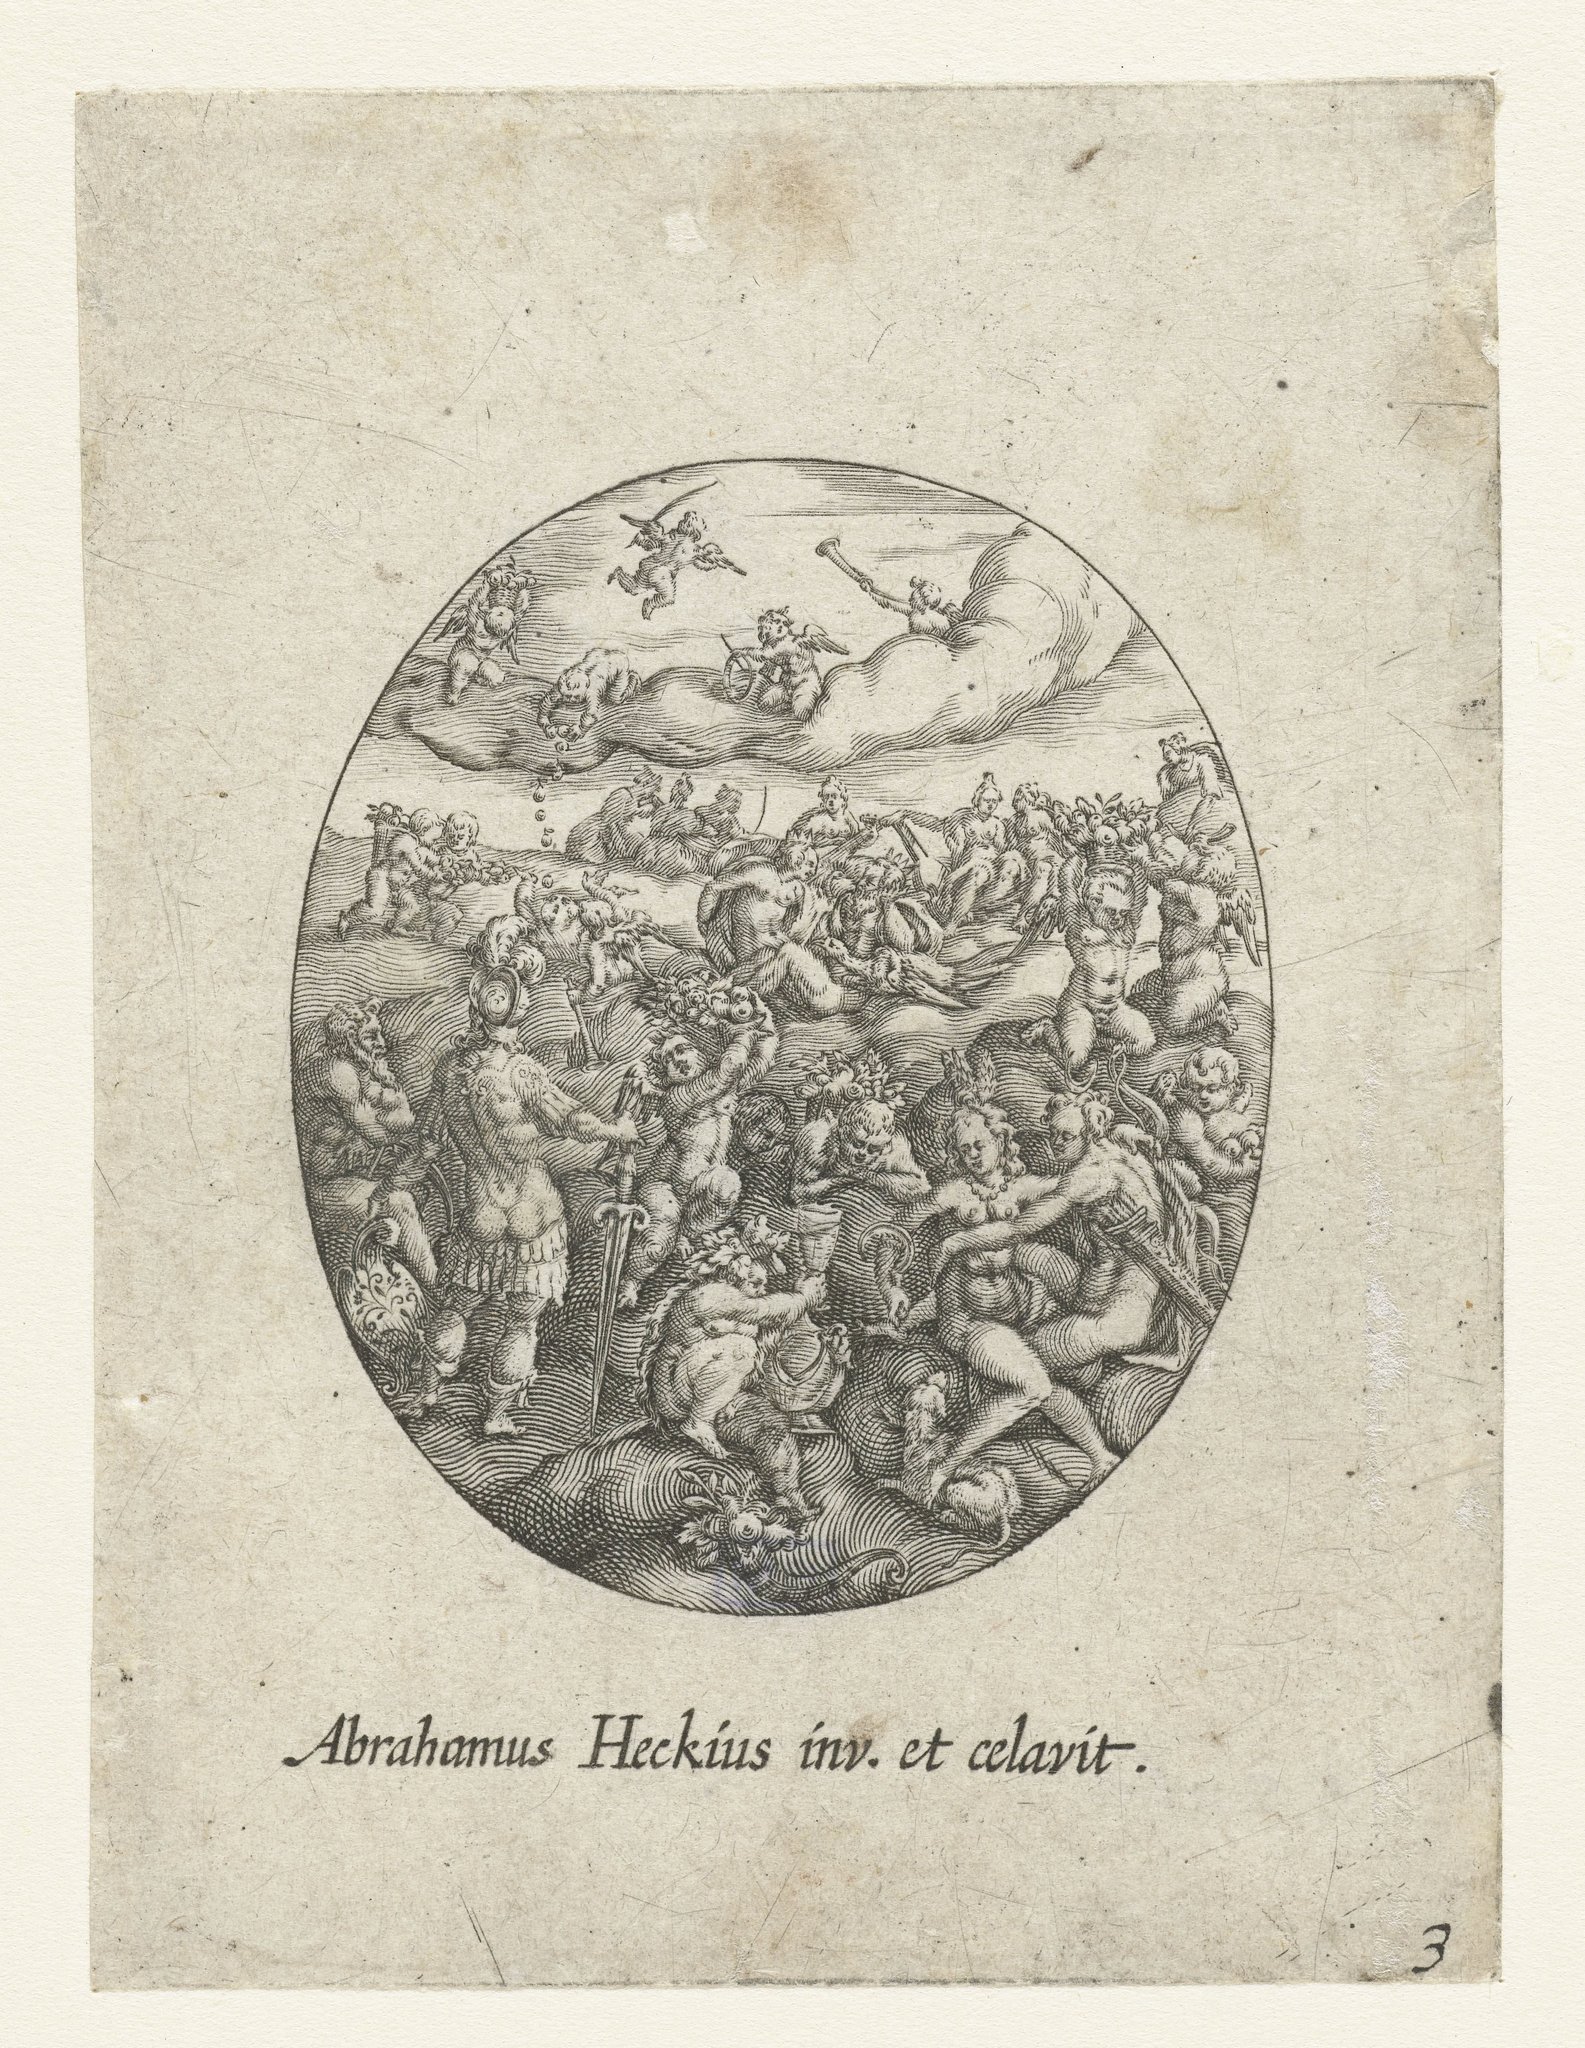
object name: print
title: Konstbüchlein den Goldschmiden dienstlich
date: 1608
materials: paper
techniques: engraving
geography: amsterdam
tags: the olympian gods together: jupiter, juno, neptune, ceres, apollo, diana, mars, venus, mercury, minerva, vulcan, vesta (or bacchus), cupids: 'amores', 'amoretti', 'putti', more than one musician with instrument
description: Van links naar rechts: Mars, Juno en Jupiter, Bacchus en Diana. Bovenaan musicerende putti. Blad 3 uit serie bestaande uit een titelblad en 11 bladen met ontwerpen voor horlogedeksels.